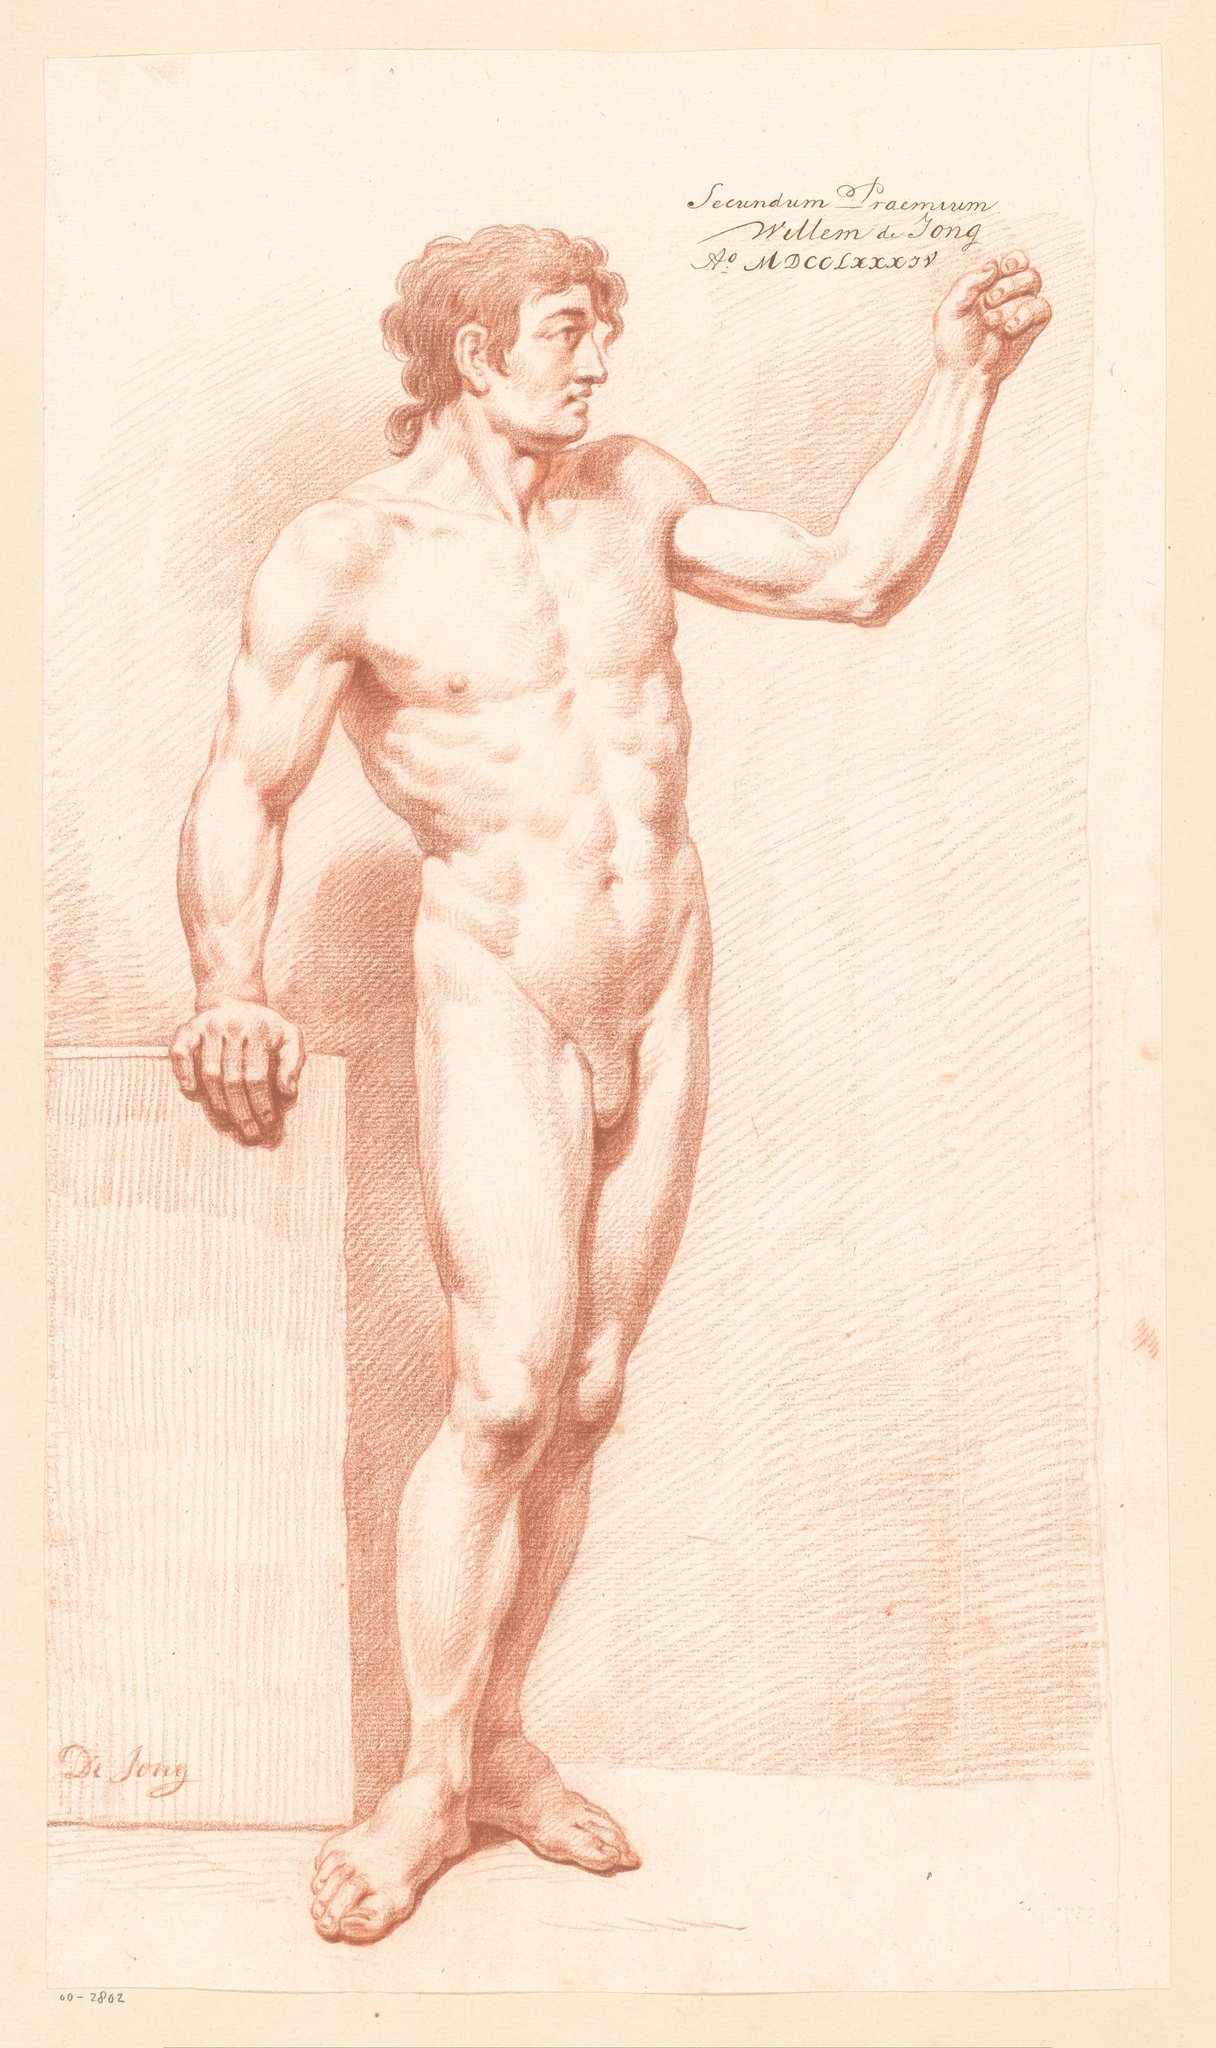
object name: drawing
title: Staand mannelijk naakt, van voren gezien (2e prijs 1784)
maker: willem de jong (tekenaar)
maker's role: draughtsman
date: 1784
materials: chalk, charcoal, paper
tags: standing figure (+ nude human being)